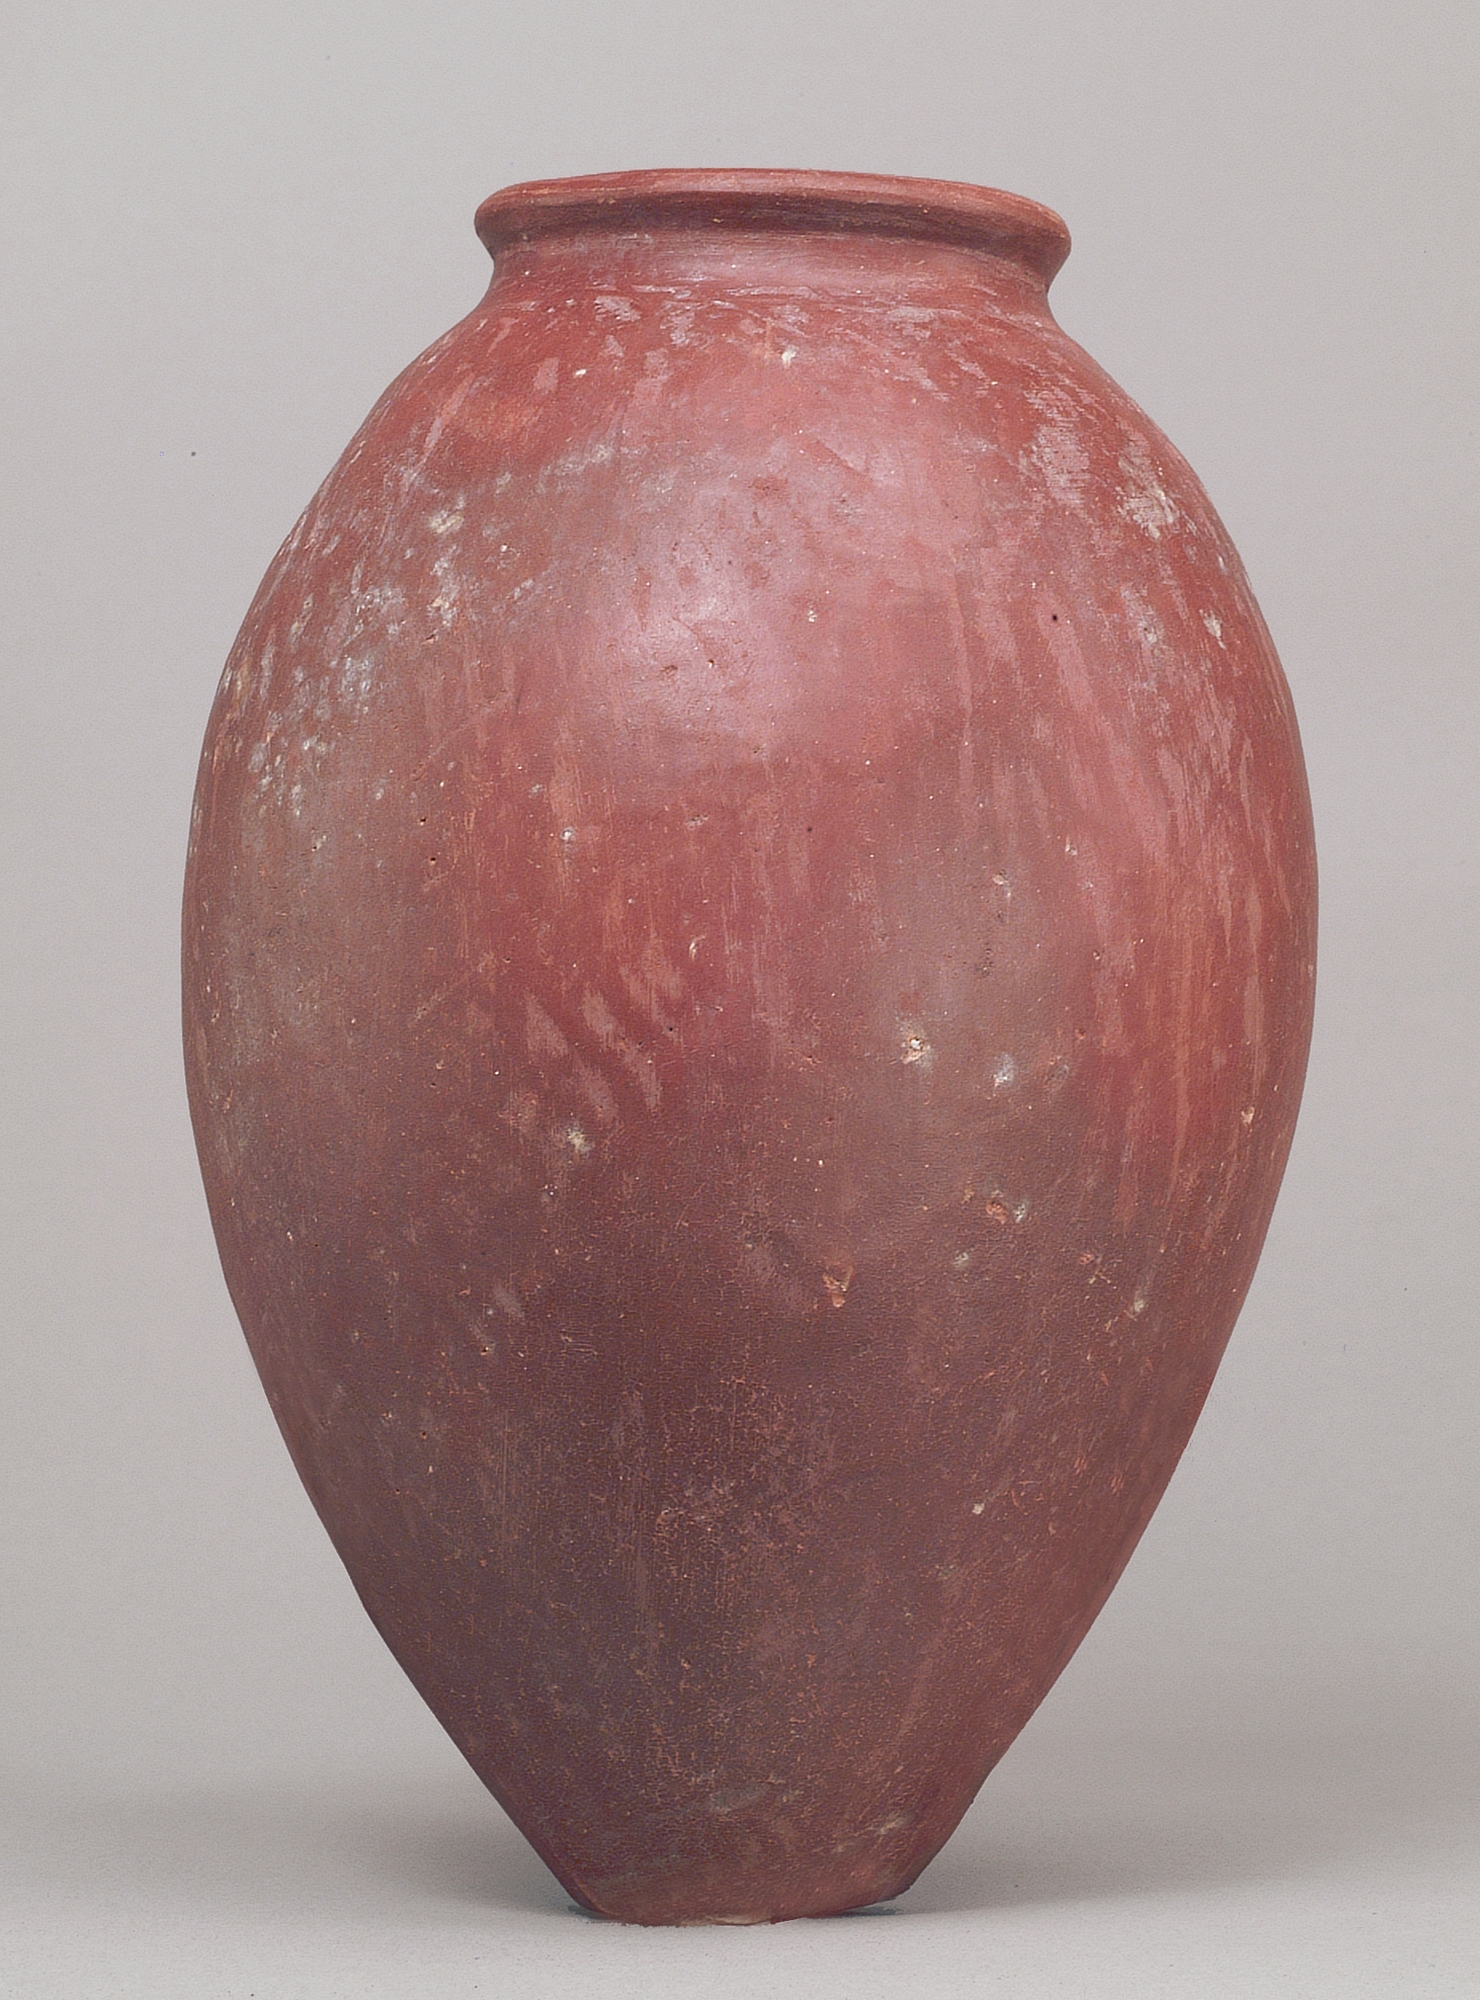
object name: jar, red polished ware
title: Red polished ware jar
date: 3650-3300 BCE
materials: pottery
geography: egypt